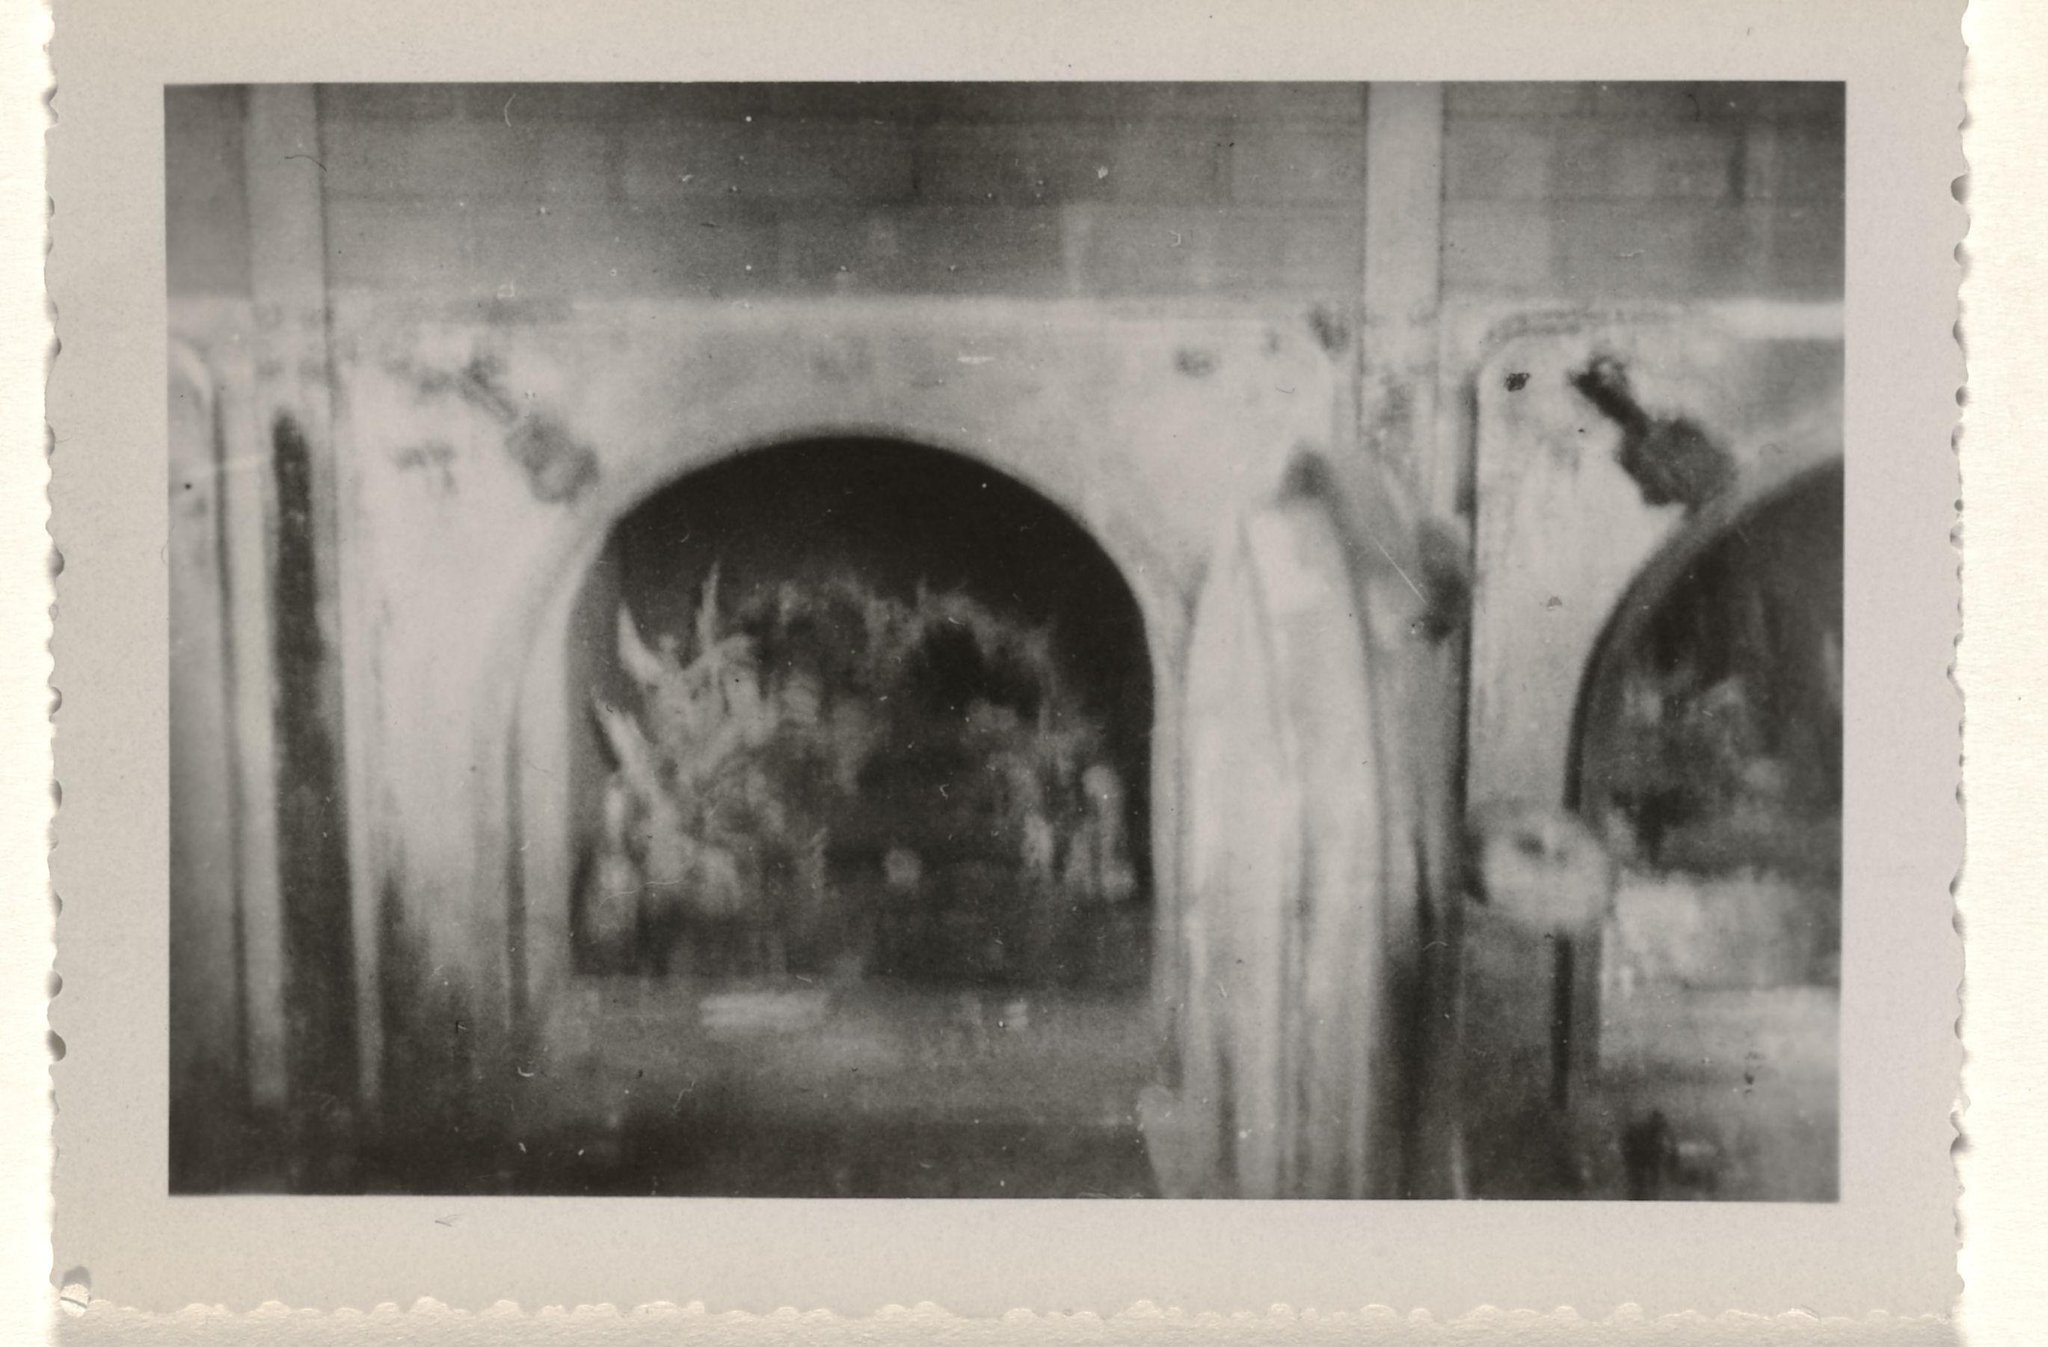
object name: photograph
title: Verbrandingsovens, april 1945?, concentratiekamp Buchenwald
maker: Anonymous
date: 1904-1945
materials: photographic support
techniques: gelatin silver print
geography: buchenwald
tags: buchenwald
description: Verbrandingsovens, april 1945?, concentratiekamp Buchenwald.